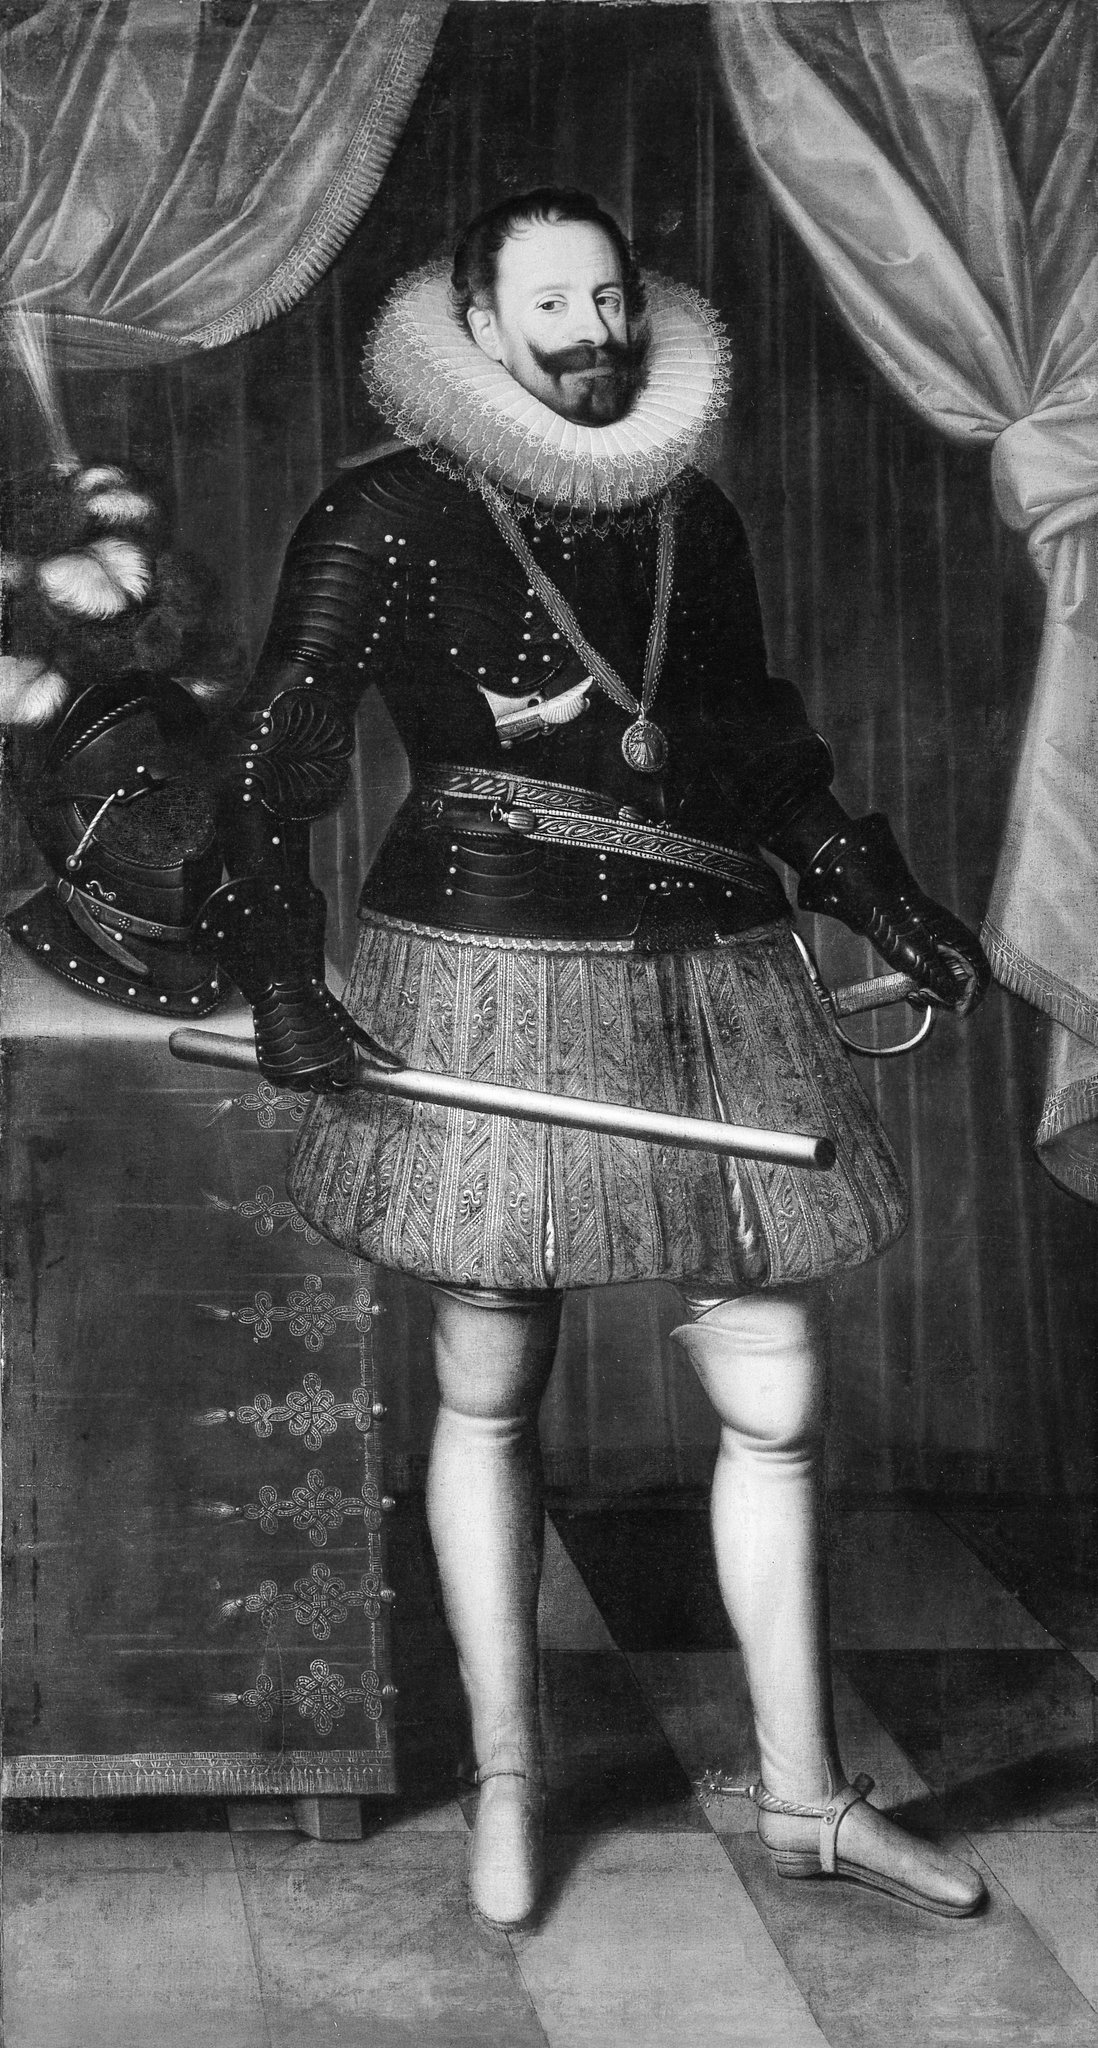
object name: painting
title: Portrait of a Man in Armor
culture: spanish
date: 1601-1633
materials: canvas, oil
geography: spain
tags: armor,men,portraits